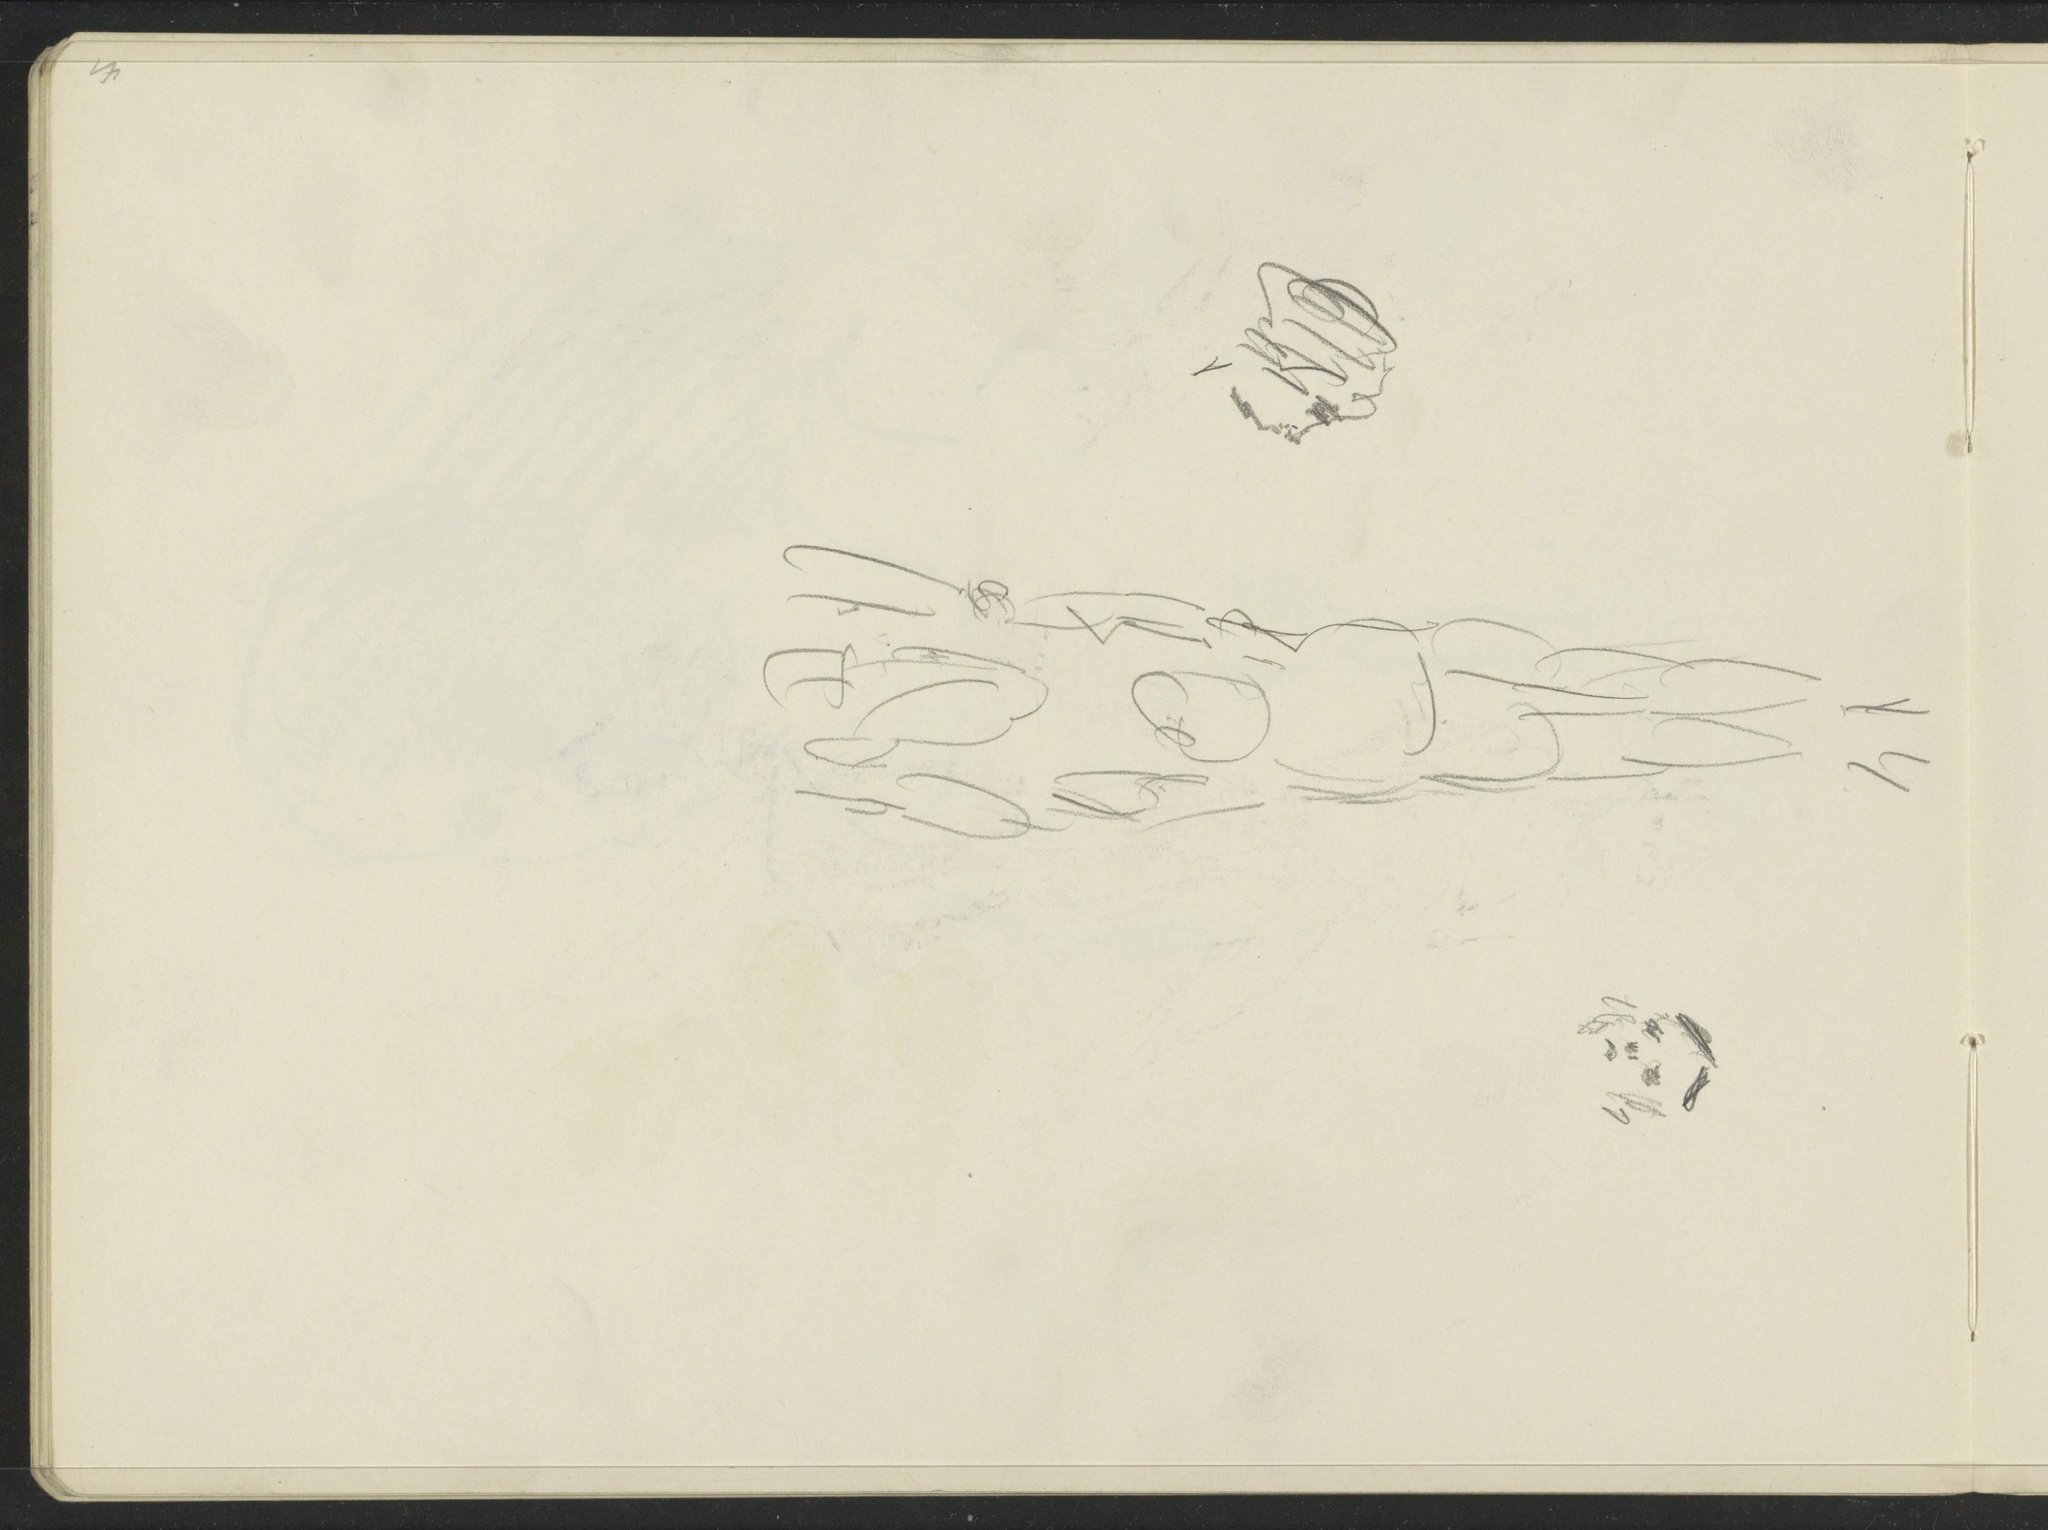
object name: sketchbook leaf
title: Acrobaat in handstand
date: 1915-1934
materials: paper, pencil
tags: head (human), monocycle, acrobat ~ circus, standing on the head or on the hands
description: Hij steunt mogelijk op een eenwieler. Verder twee studies van hoofden. Blad 24 verso uit schetsboek XVI met 32 bladen.